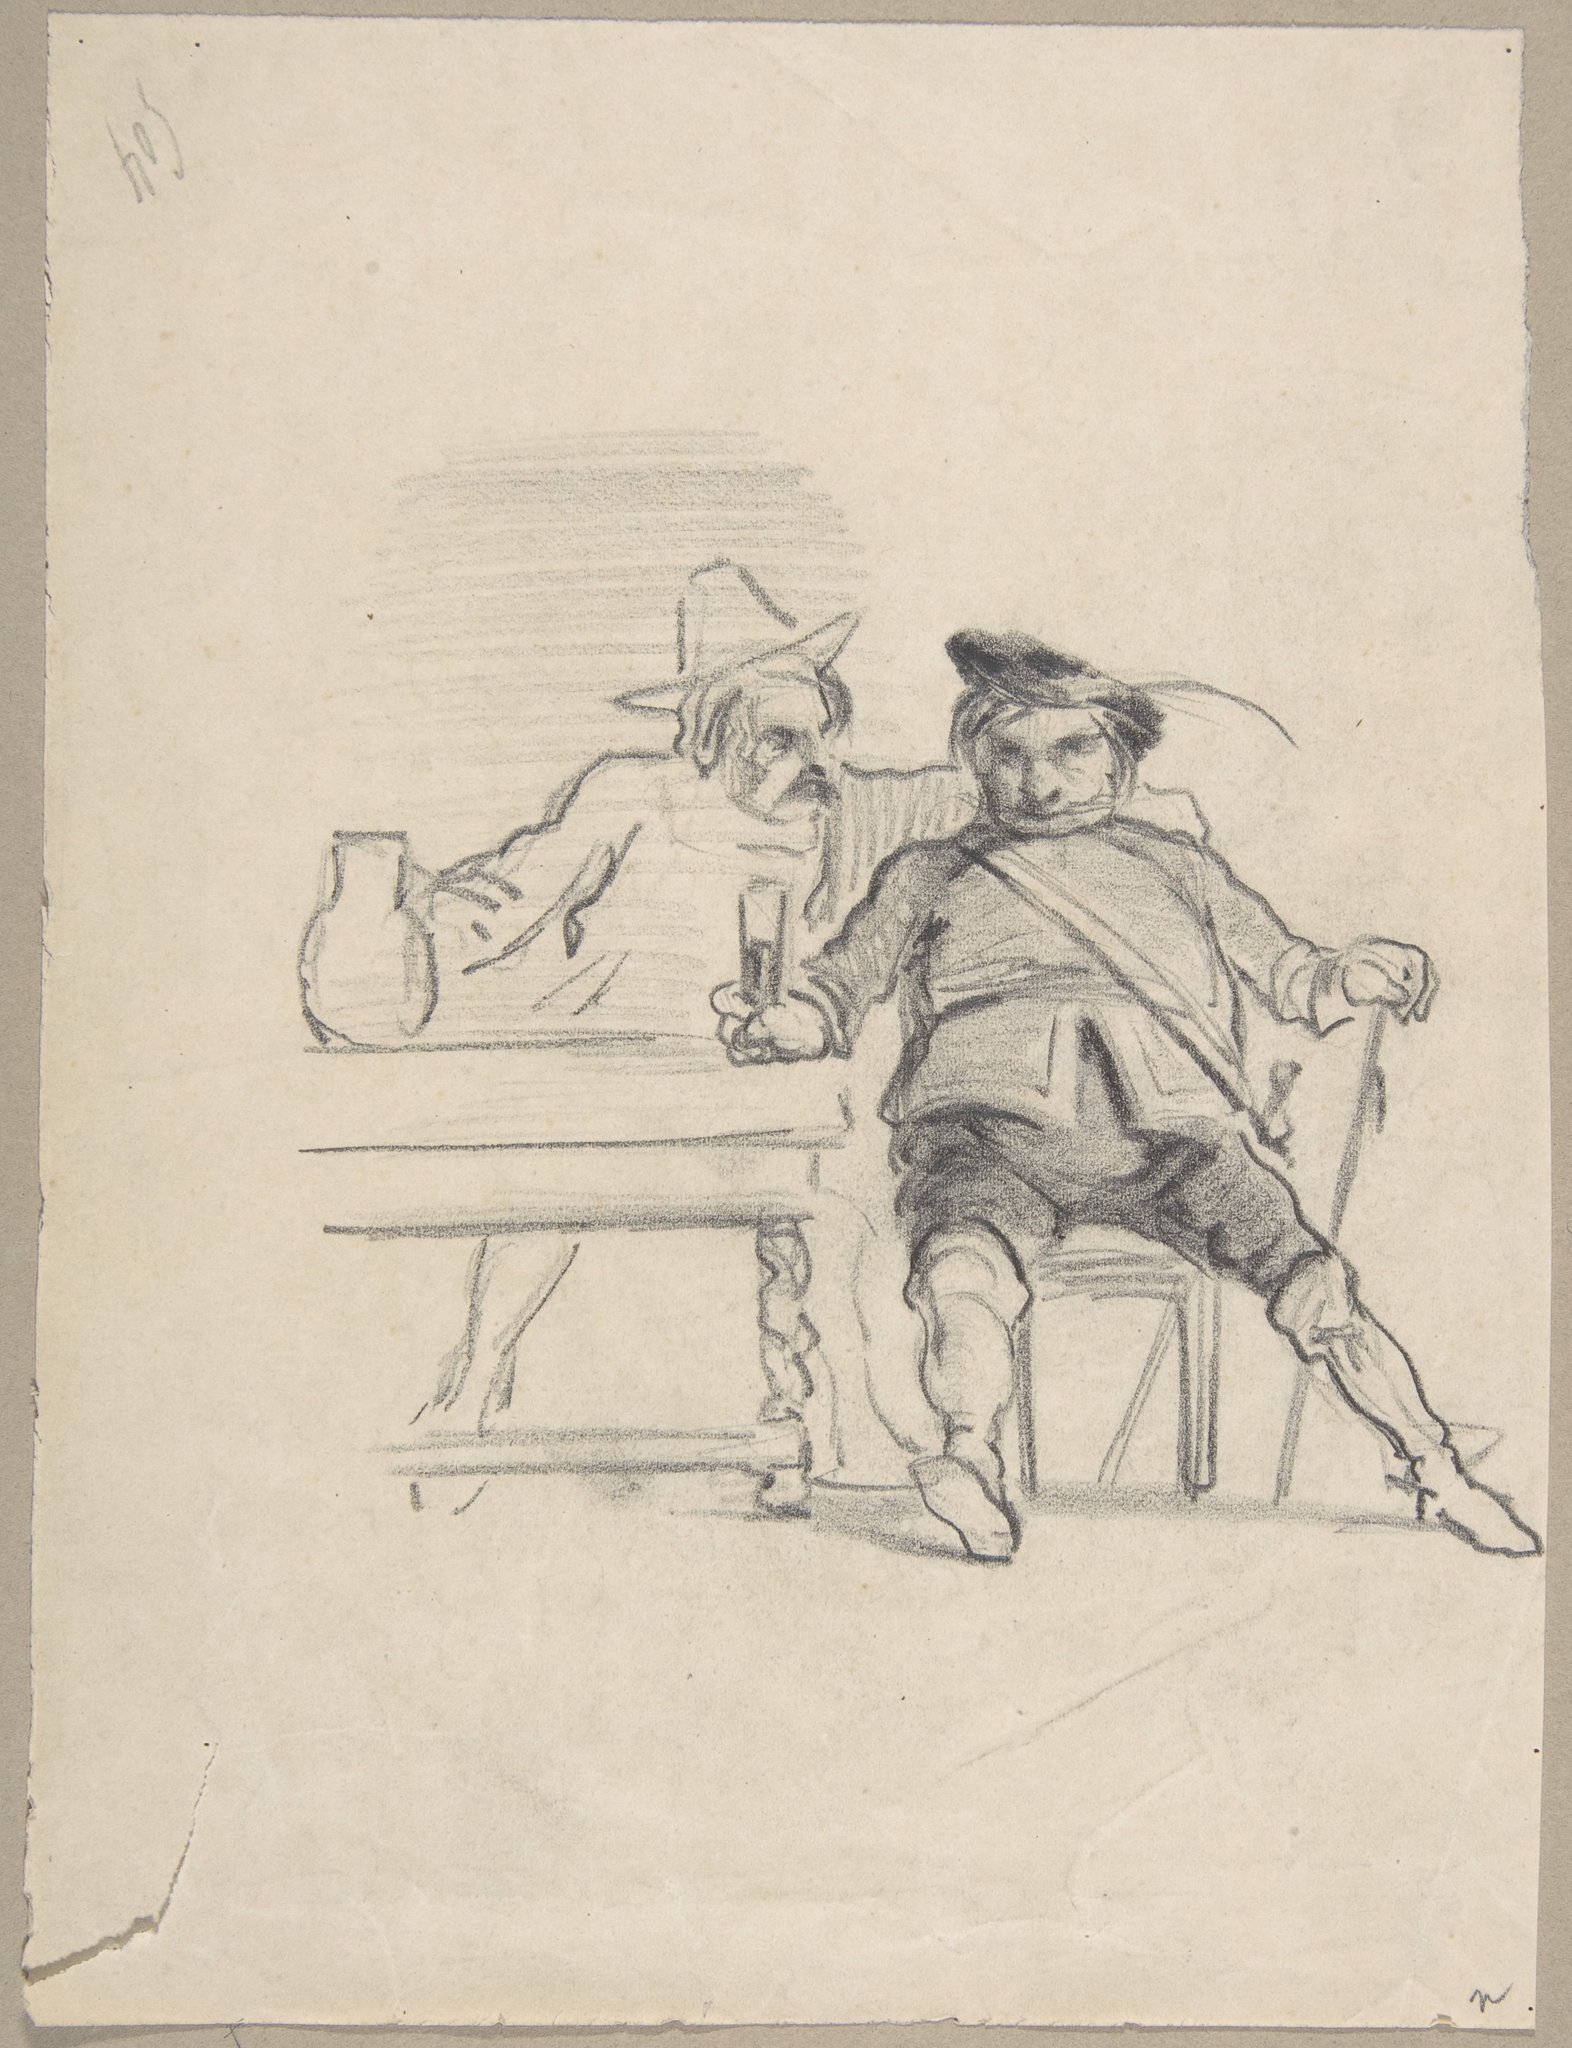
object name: drawing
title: Two male figures seated at a table, drinking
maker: félicien rops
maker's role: artist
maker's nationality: belgian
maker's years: 1833-1898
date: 1833-1898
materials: graphite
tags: men,drinking,tables